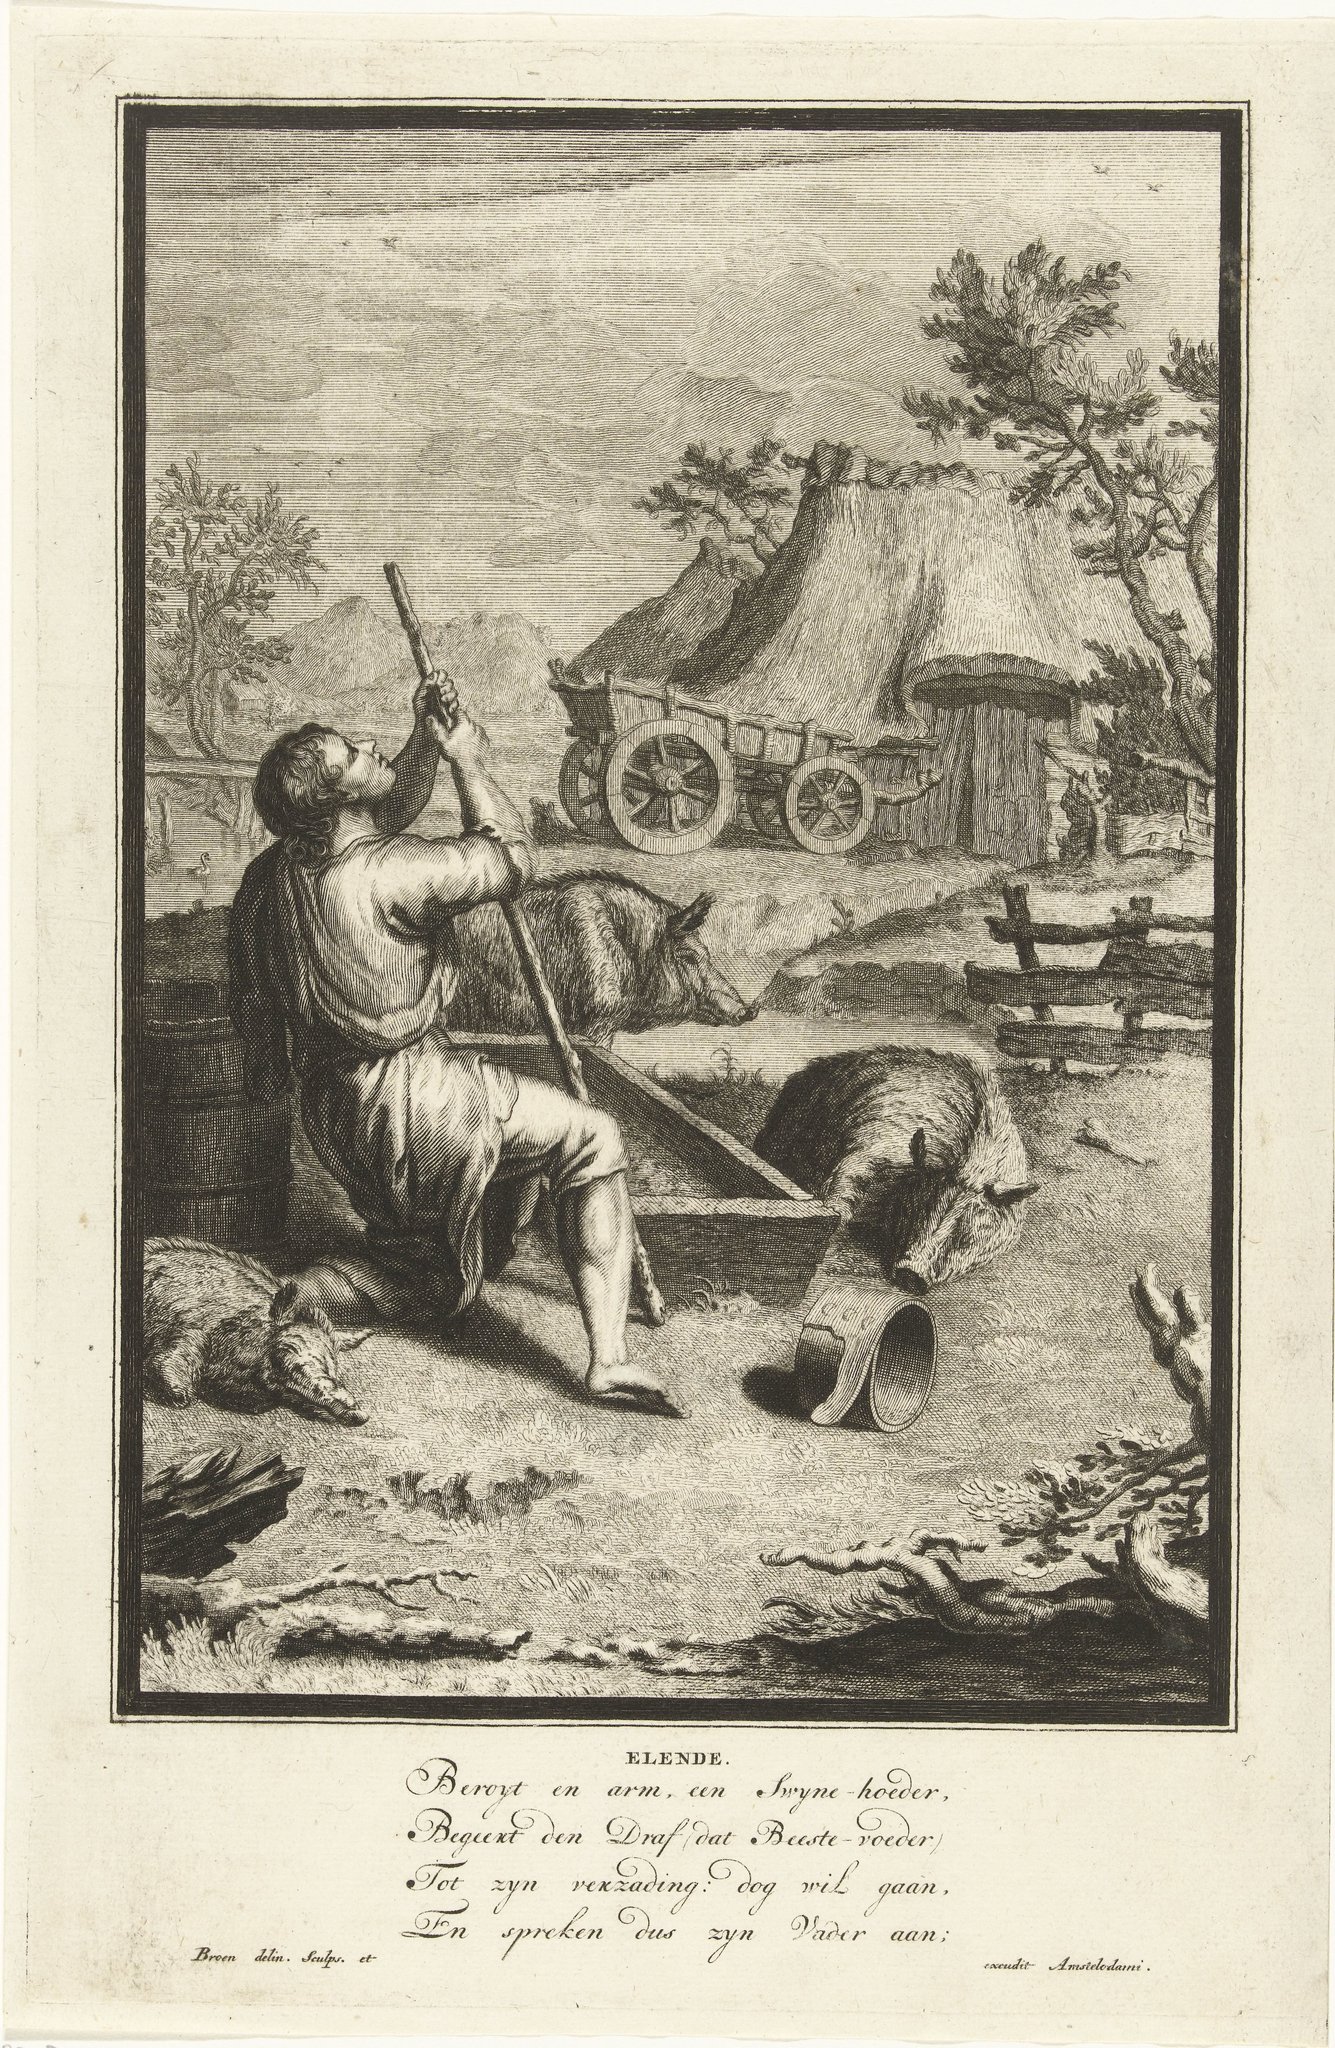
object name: print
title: Elende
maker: gerrit de broen (i)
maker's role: print maker, publisher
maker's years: 1659-1740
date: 1684-1740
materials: paper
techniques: engraving, etching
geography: amsterdam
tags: the parable of the prodigal son (luke 15:11-32)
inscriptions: collector's mark: Lugt 2228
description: Het erfdeel van de verloren zoon is op en nu moet hij als varkenshoeder werken. Hij hurkt naast de voederbak van de varkens; zijn blik gaat naar de hemel. De varkens slapen naast hem.